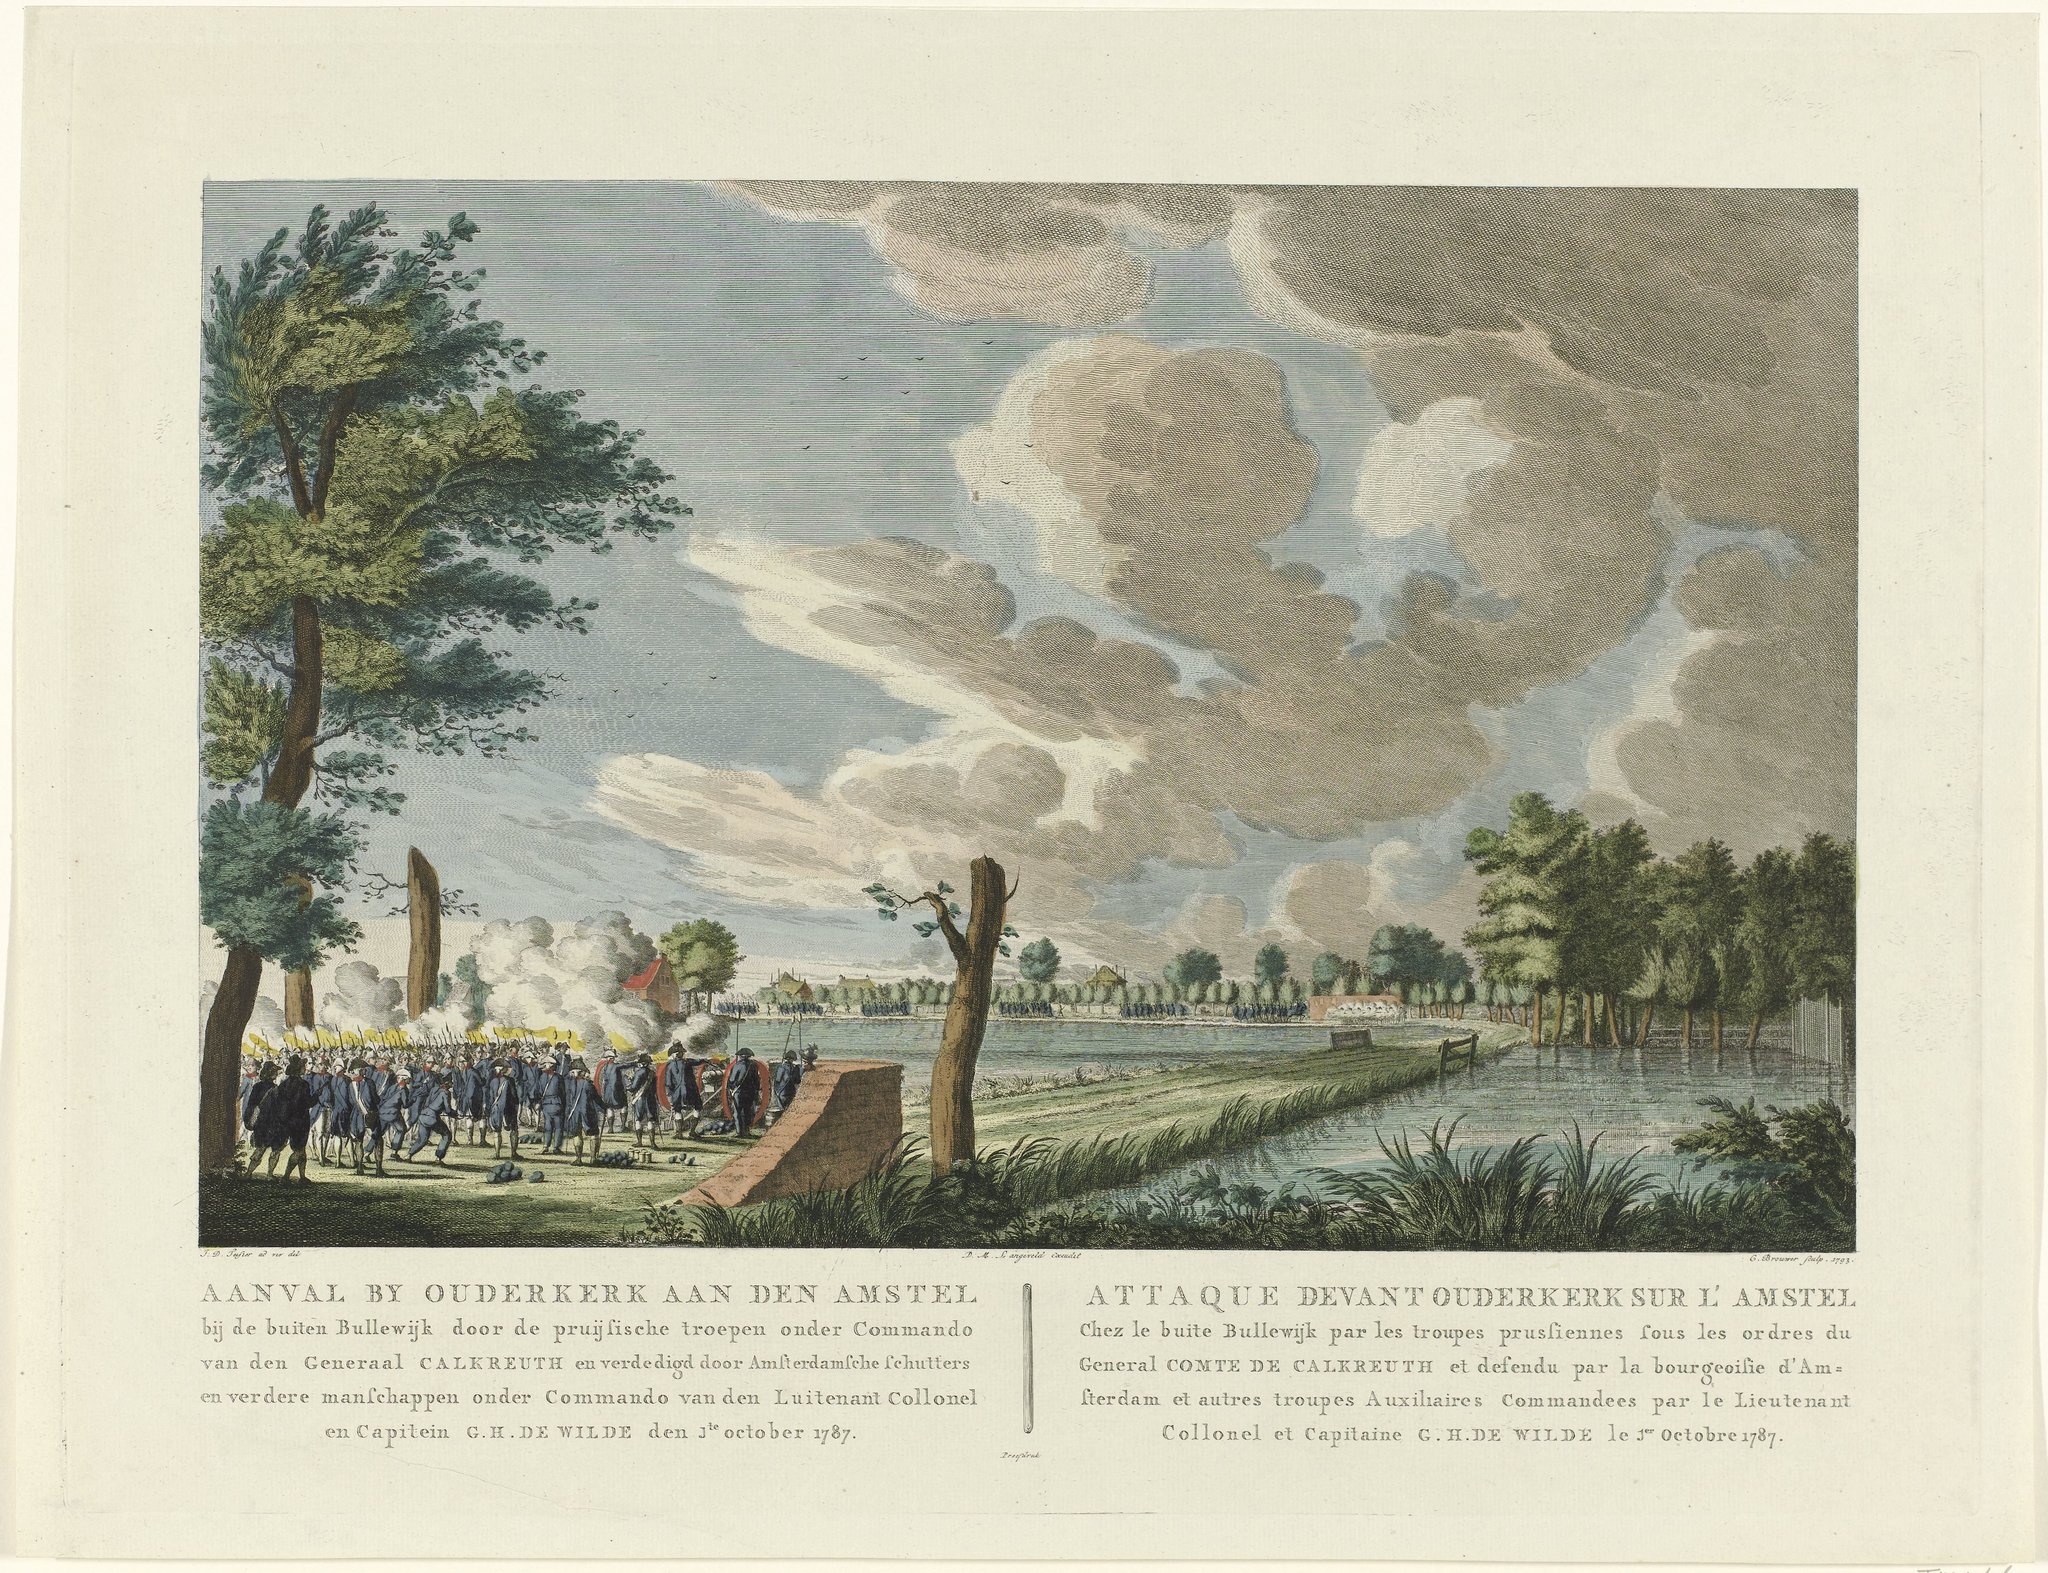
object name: history print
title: Aanval bij Ouderkerk aan de Amstel, 1787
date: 1793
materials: paper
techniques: engraving, etching, hand coloring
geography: ouderkerk aan de amstel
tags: (military) attack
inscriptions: collector's mark: Lugt 2228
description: Aanval bij de Bullewijk bij Ouderkerk aan de Amstel door de Pruisische troepen onder commando van generaal Friedrich Adolf von Kalckreuth, verdedigd door Amsterdamse schutters onder commando van kolonel George Hendrik de Wilde, 1 oktober 1787. Onderdeel van een groep van zeven prenten van de gevechten met de Pruissische troepen rond Amsterdam in 1787.